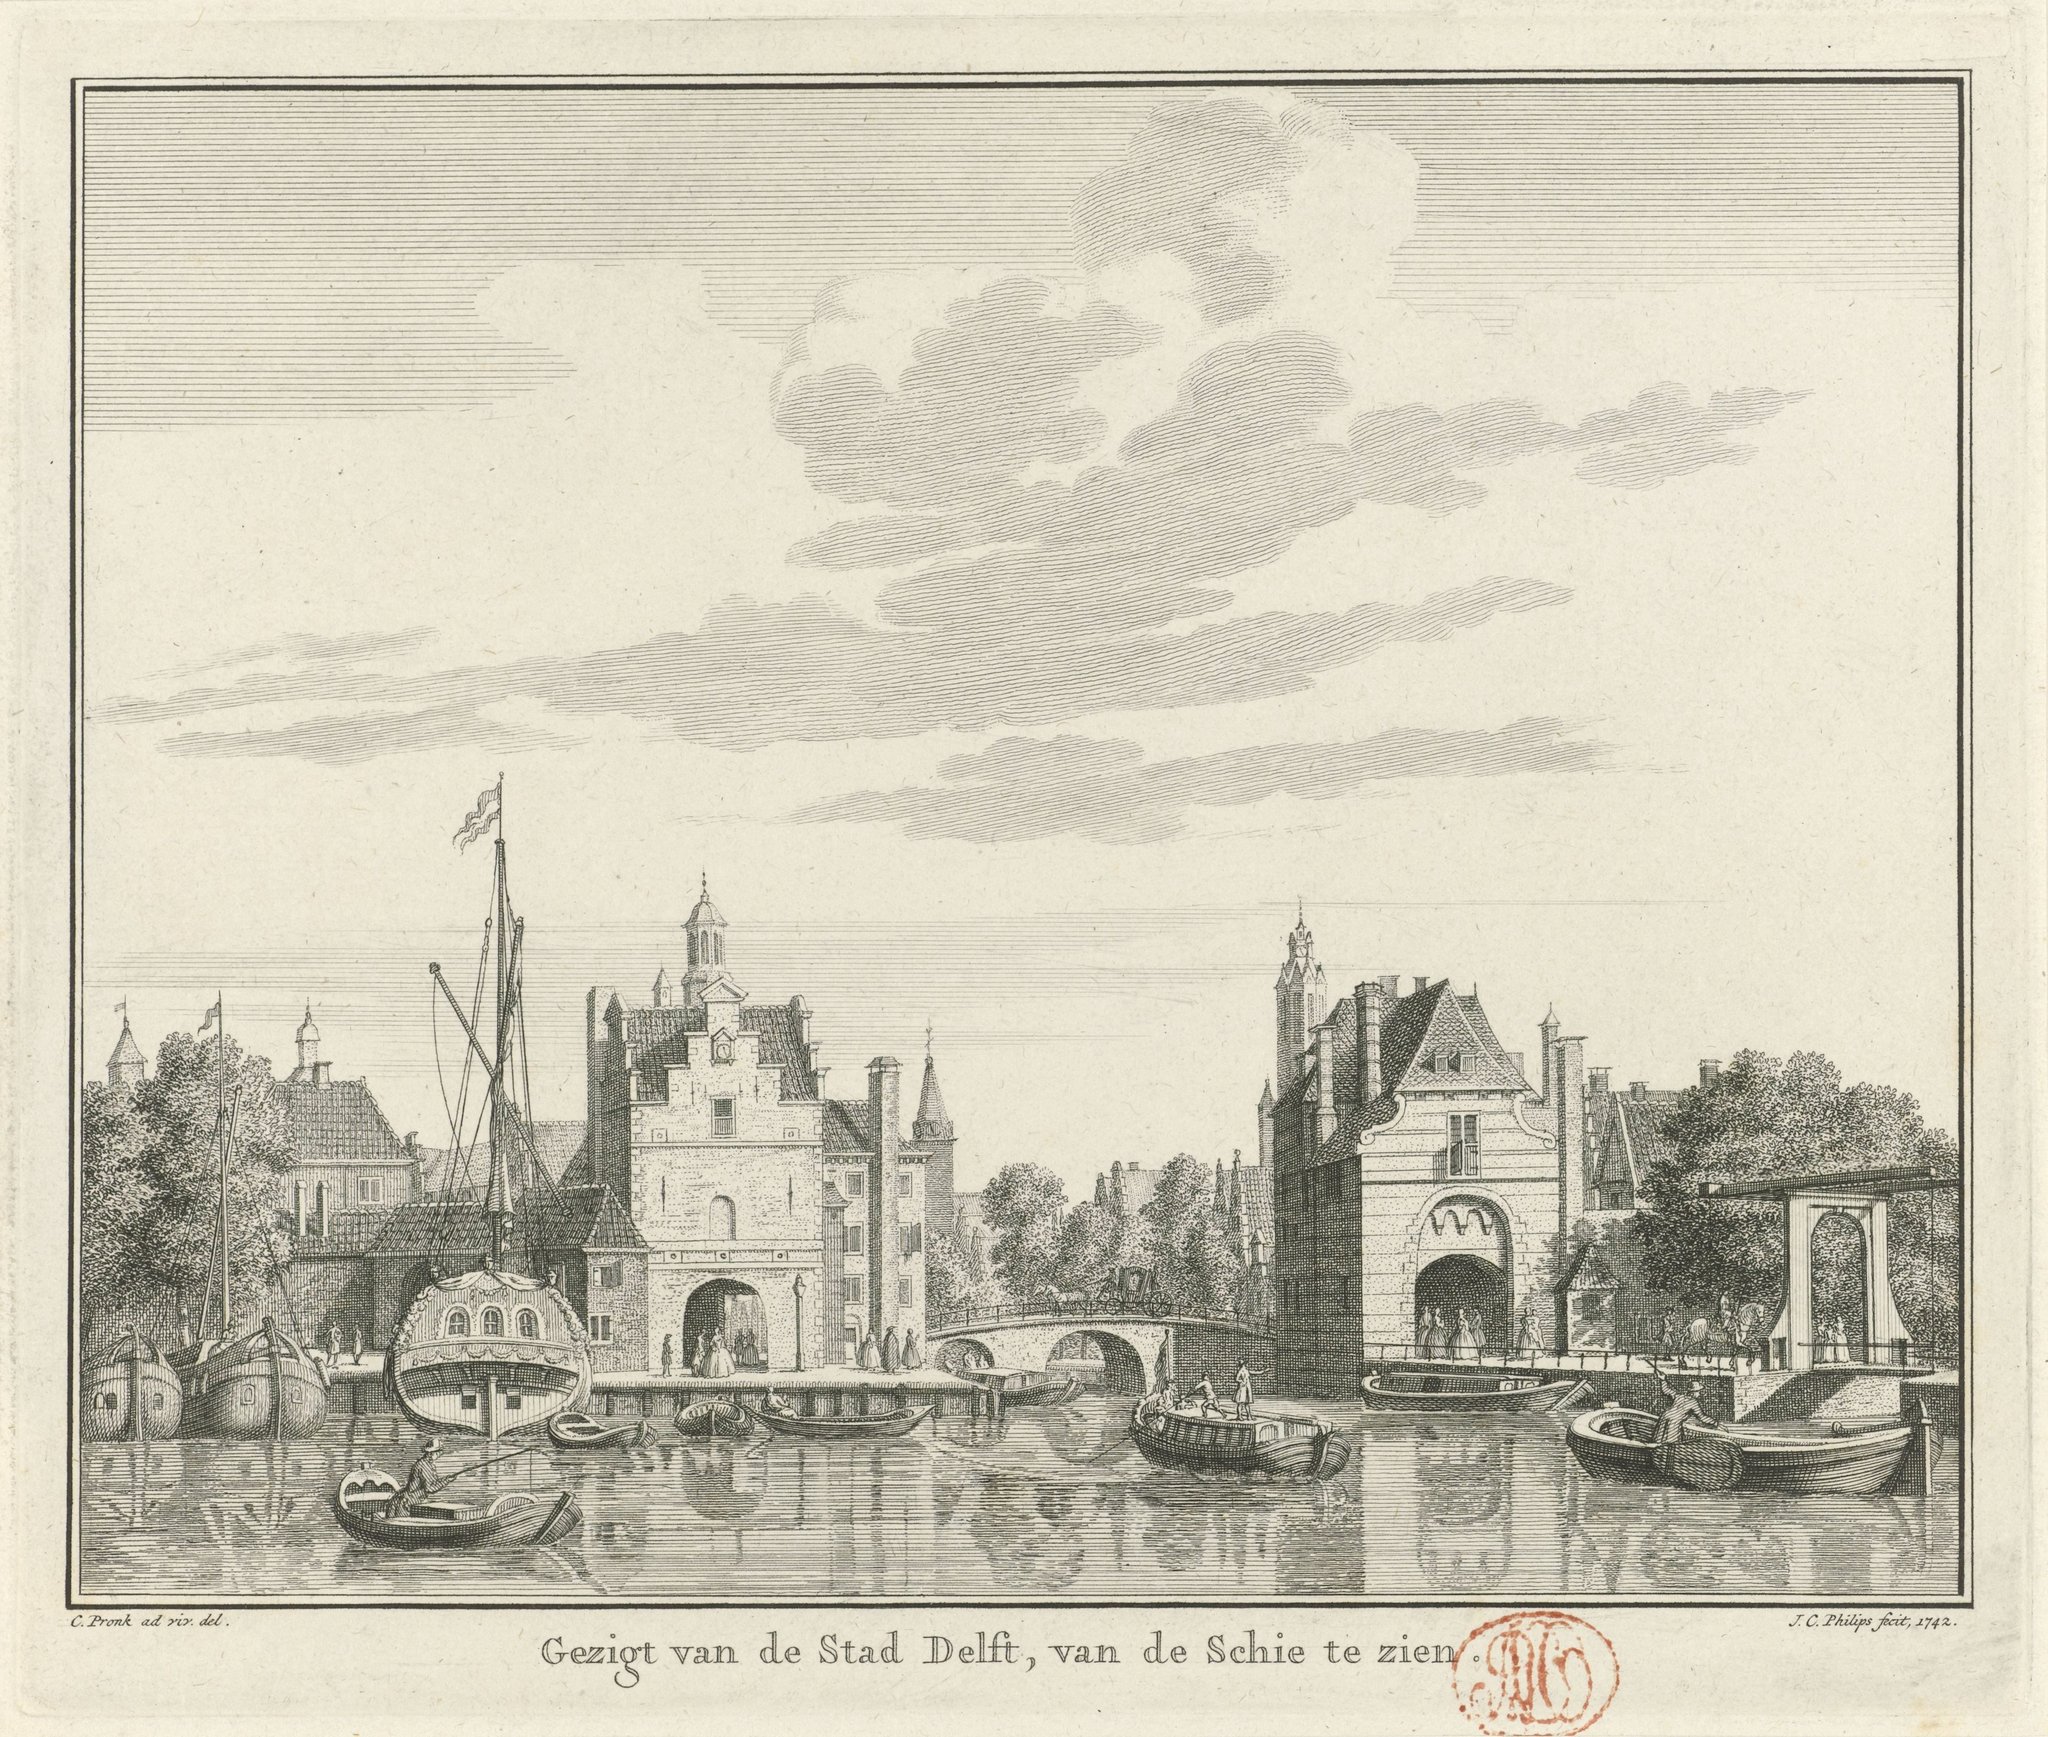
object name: print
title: Gezicht op Delft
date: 1742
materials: paper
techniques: etching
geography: amsterdam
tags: city-view in general; 'veduta', delft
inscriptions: collector's mark: Lugt 195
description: Prent ook gebruikt als illustratie in: Tegenwoordige staat der Vereenigde Nederlanden; vierde deel. Behelzende eenen aanvang der beschryvinge van Holland. Amsterdam: Isaak Tirion, 1742.